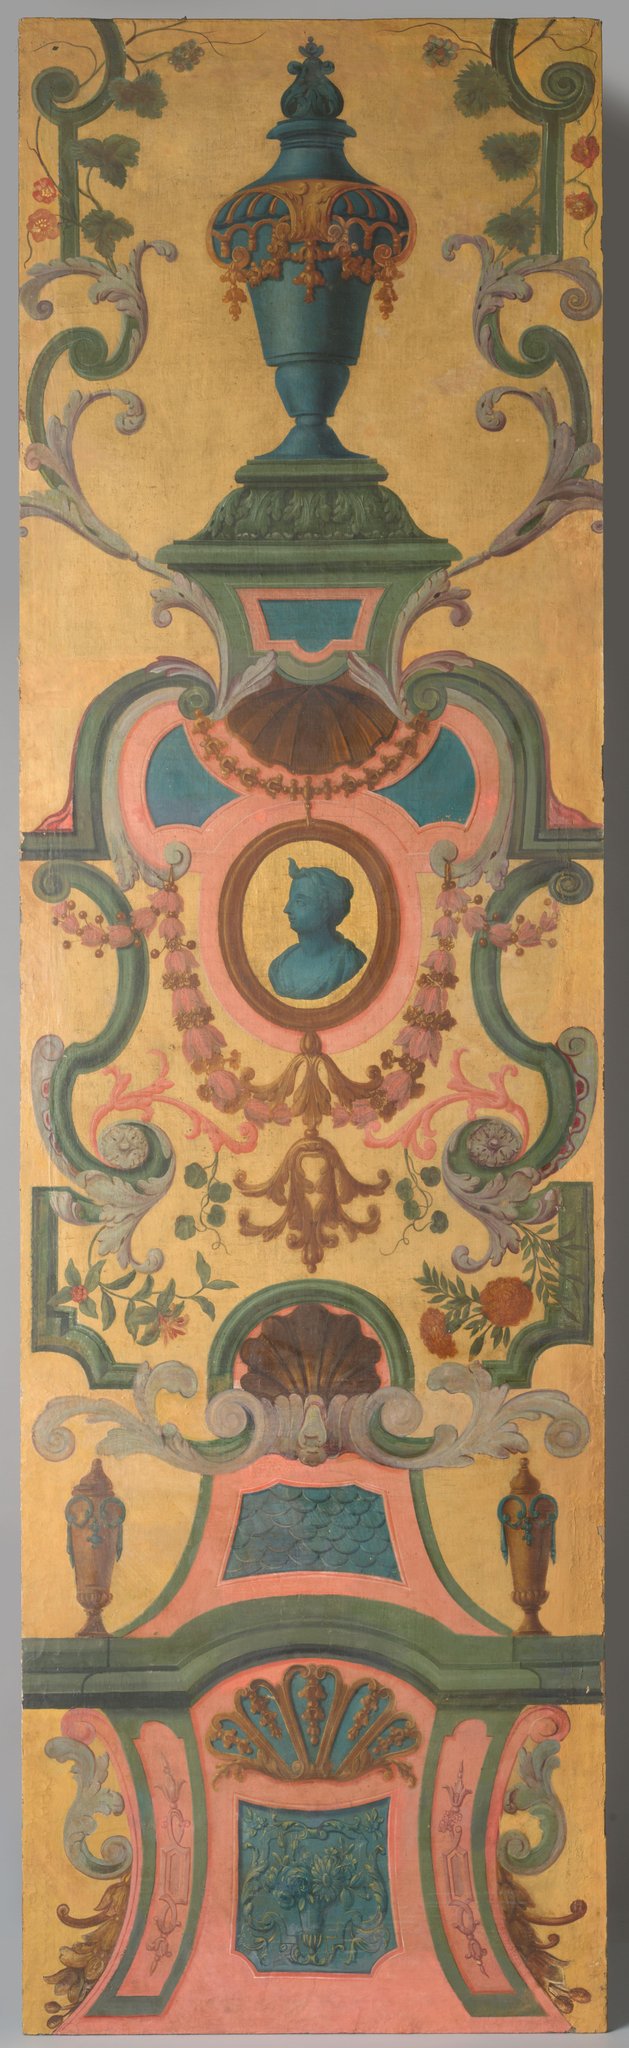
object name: vouwscherm, kamerscherm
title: Onderdeel van een kamerscherm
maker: Anonymous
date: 1700-1750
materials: linen, wood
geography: netherlands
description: Onderdeel van een kamerscherm van zes slagen, bespannen met beschilderd linnen waarop piedestals, vazen met bloemen, medaillons en vogels in diverse kleuren zijn aangebracht.